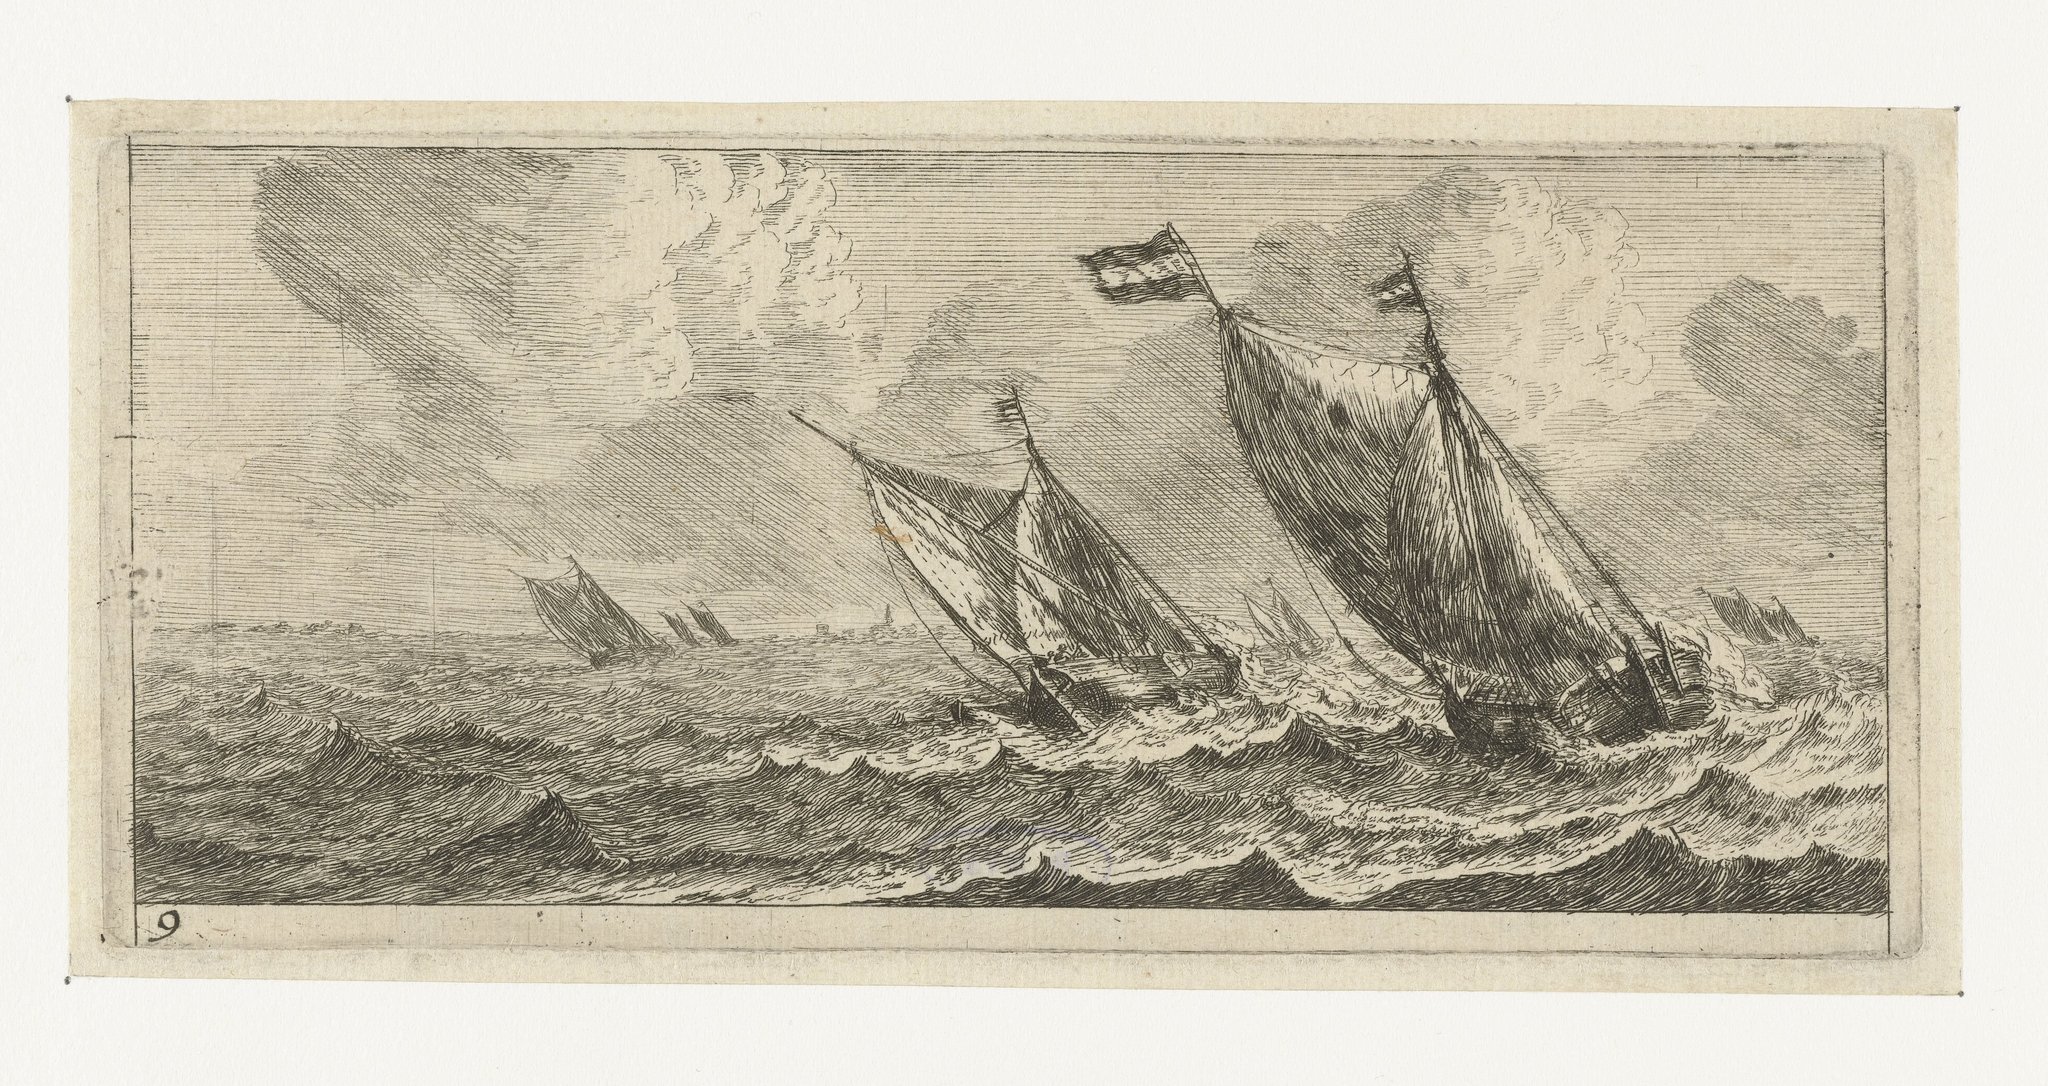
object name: print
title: Divers Embarquements et autre Faicts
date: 1651-1652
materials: paper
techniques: etching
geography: amsterdam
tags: sailing-ship, sailing-boat, ferry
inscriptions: collector's mark: Lugt 2228a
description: Een ruwe zee met een aantal veerschepen.